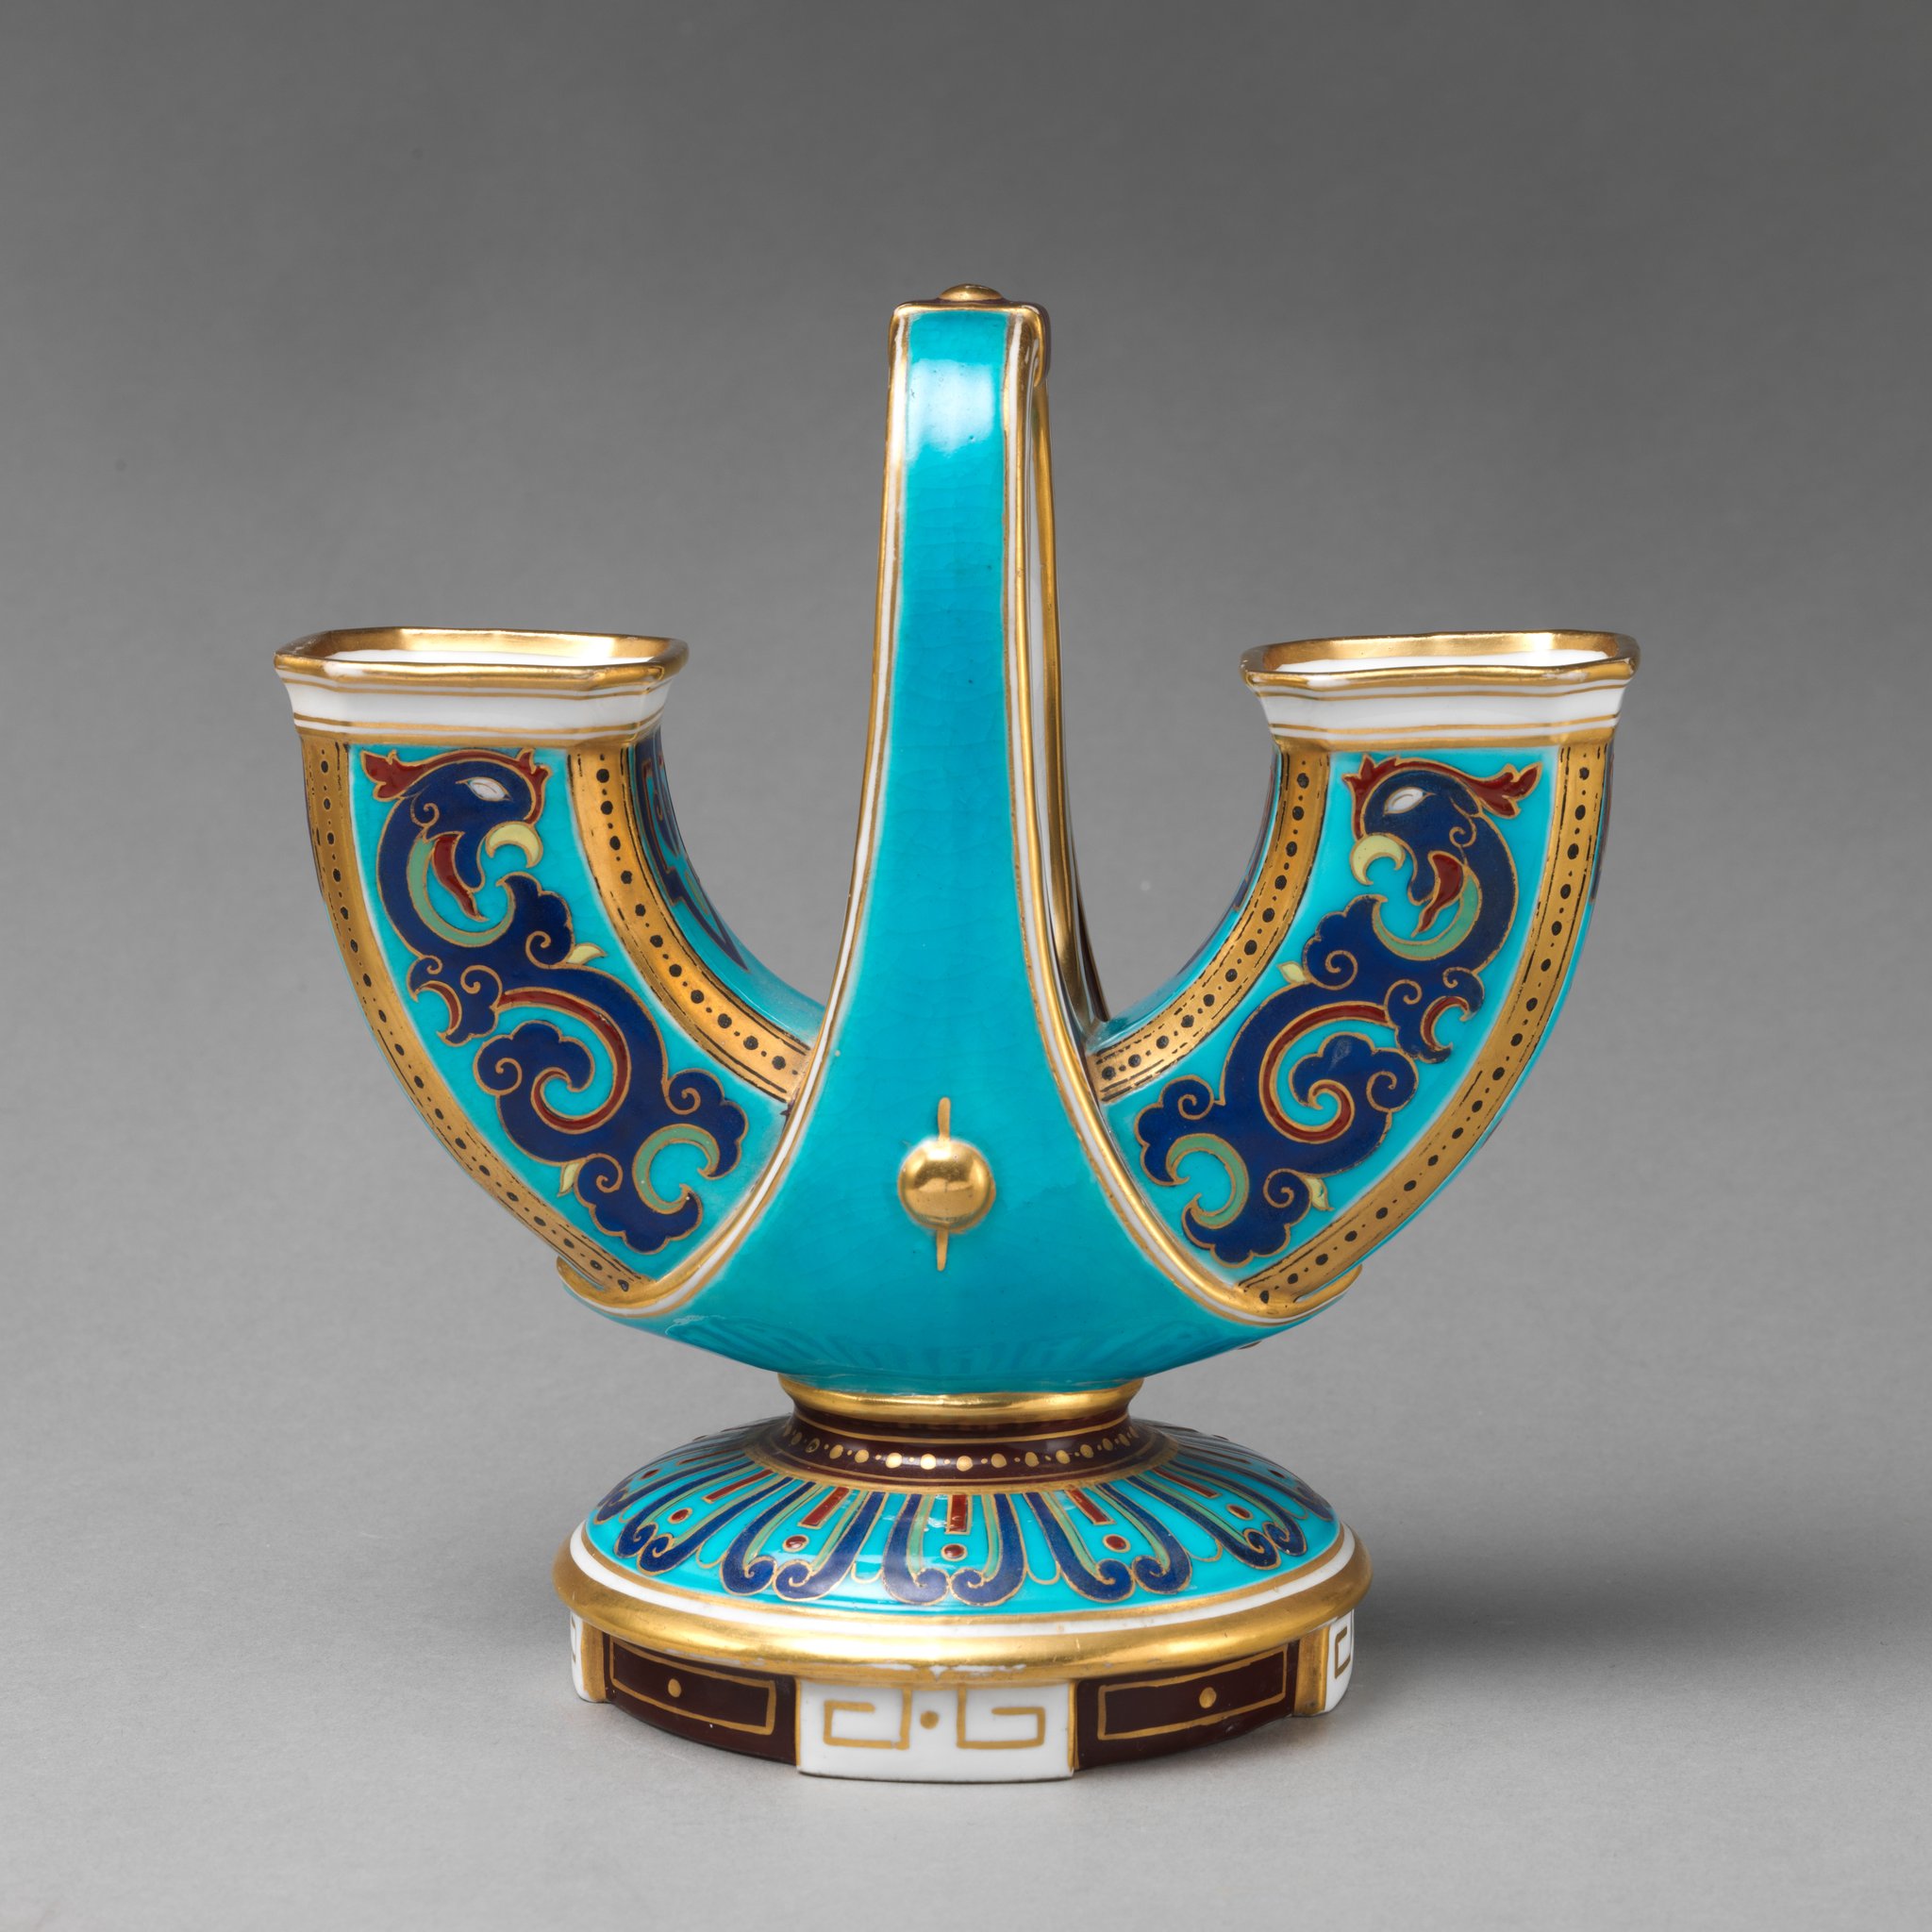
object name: vase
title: U-shaped vase with handle (one of a pair)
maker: minton(s)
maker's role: maker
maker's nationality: british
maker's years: 1793-2001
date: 1869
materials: bone china